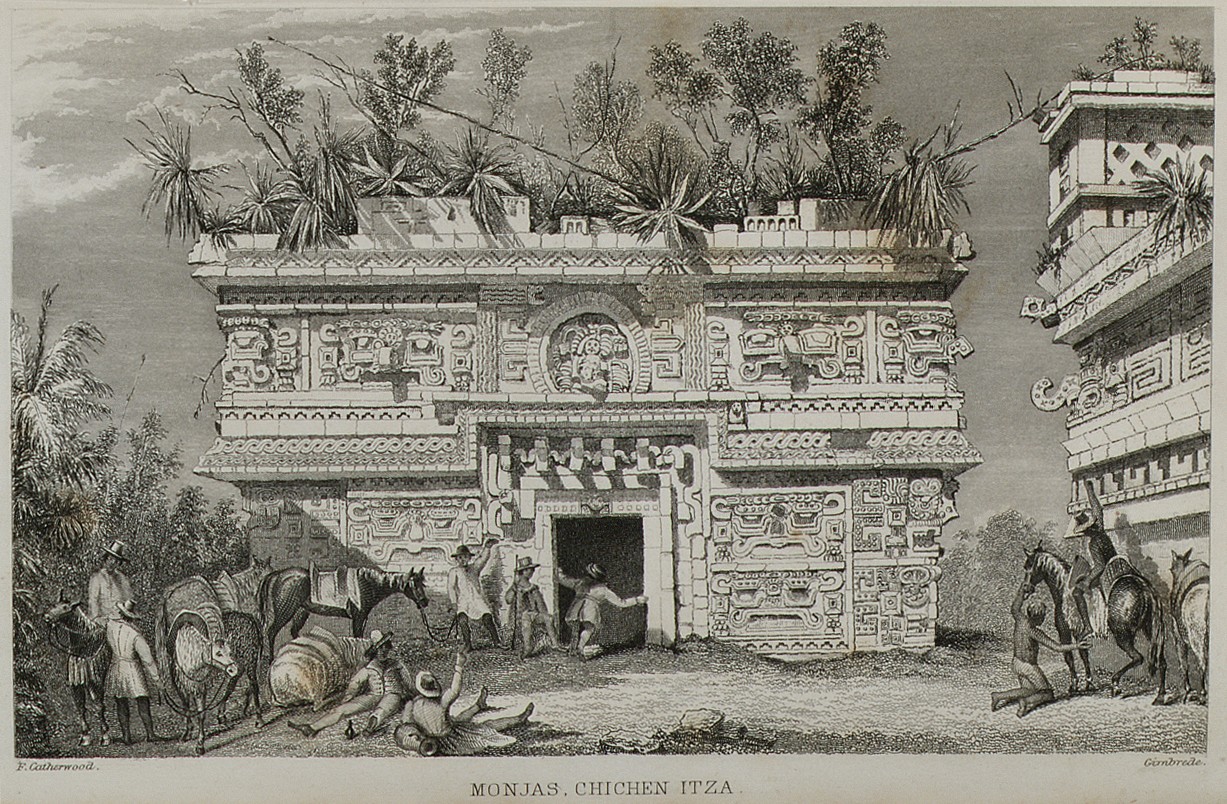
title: Incidents of Travel in Yucatan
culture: american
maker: john lloyd stephens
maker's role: author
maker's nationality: american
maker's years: 1805-1852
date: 1843